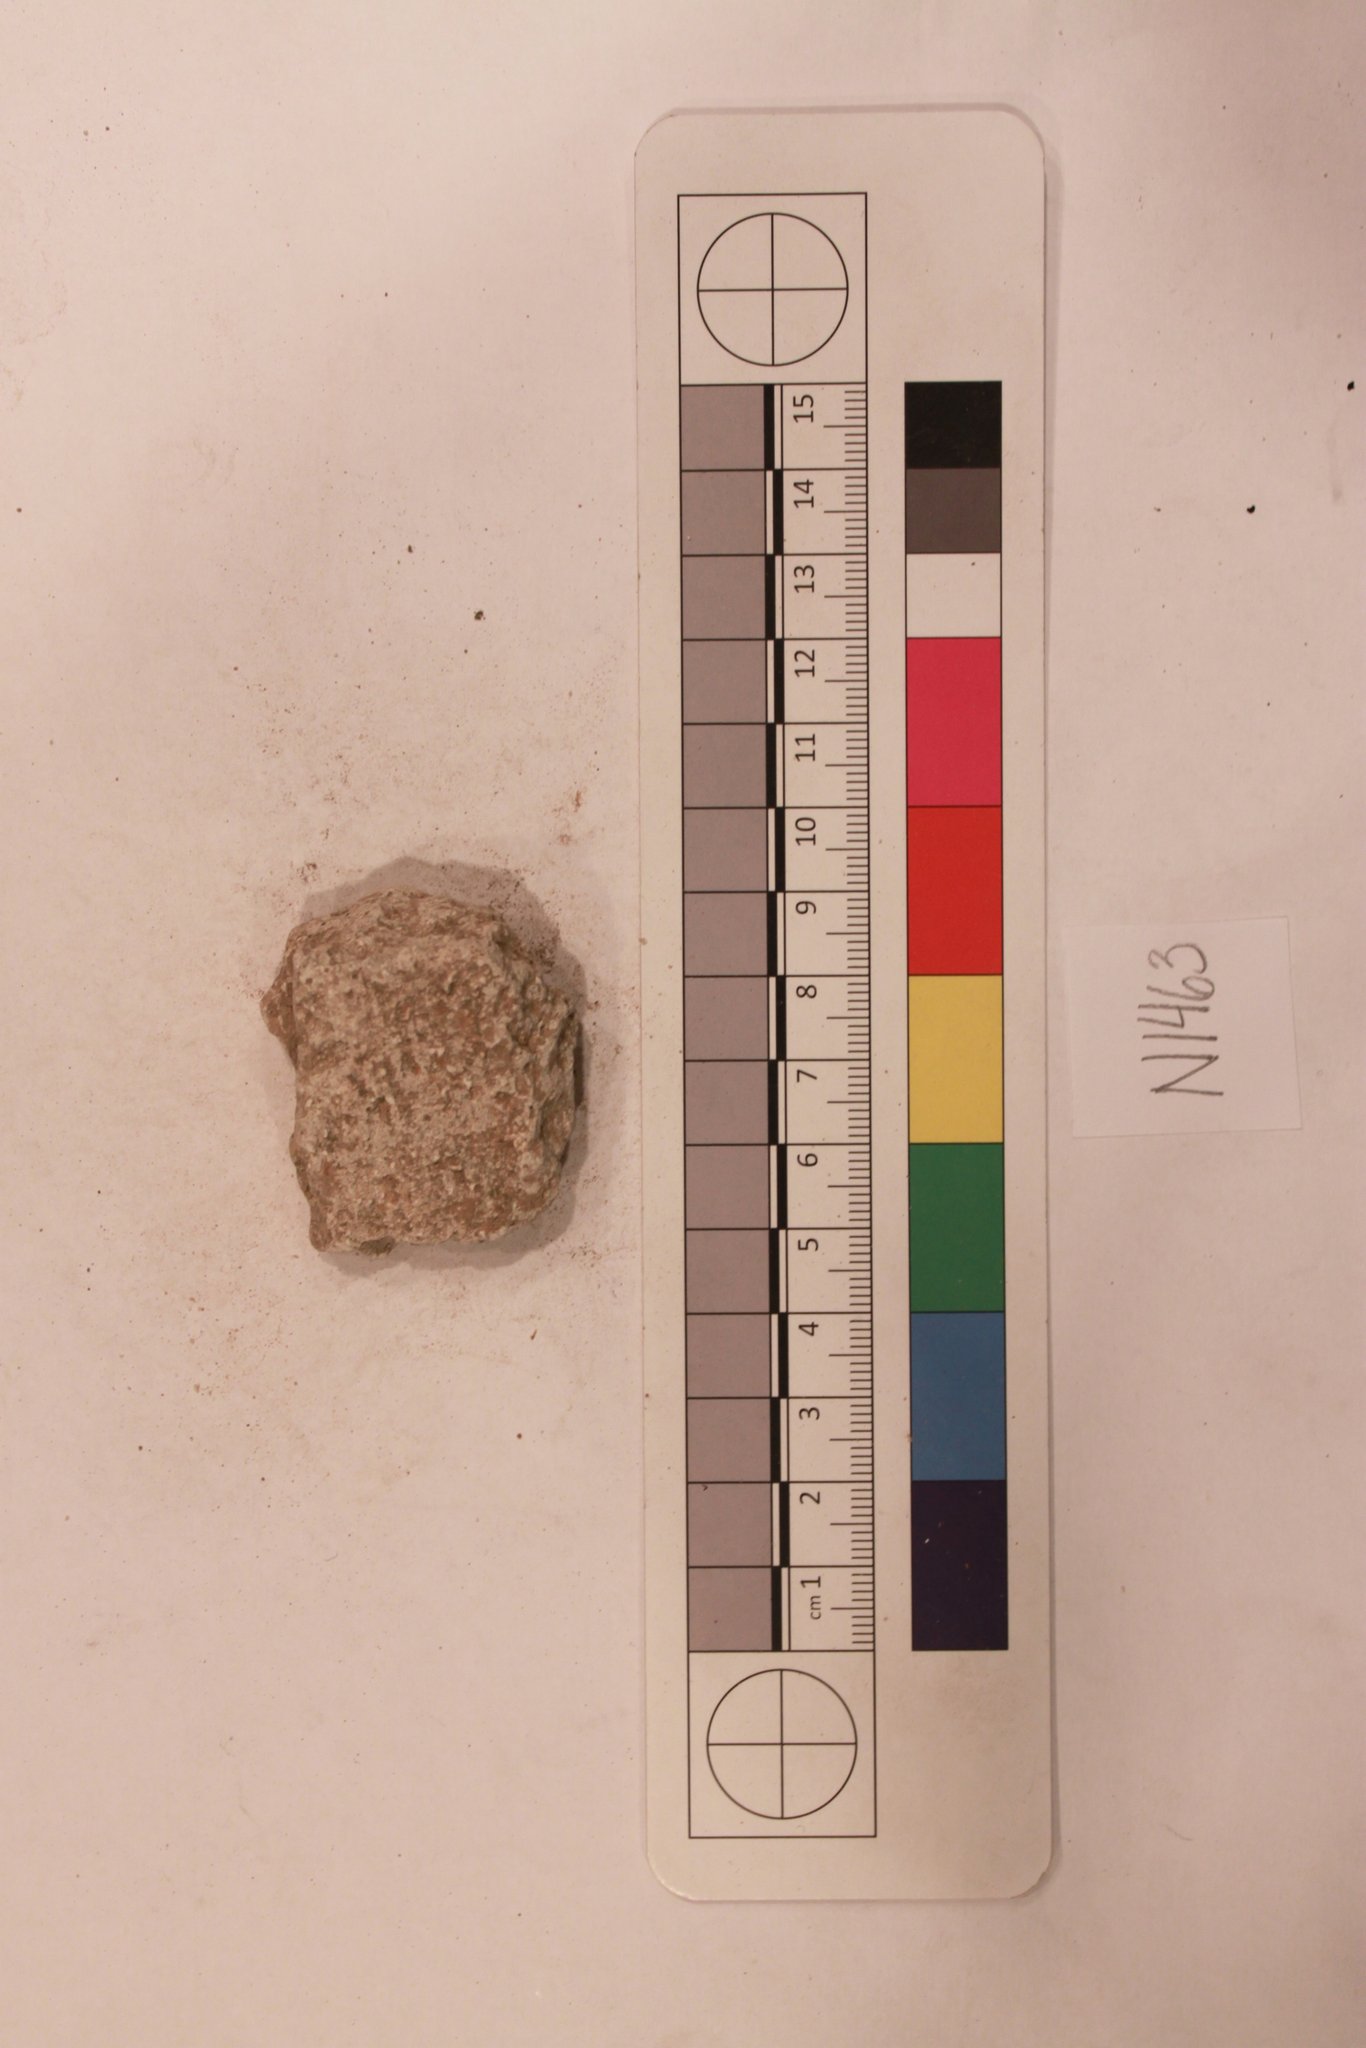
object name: fragment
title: Stucco Fragment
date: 701-1200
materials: plaster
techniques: carving, painting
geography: iran